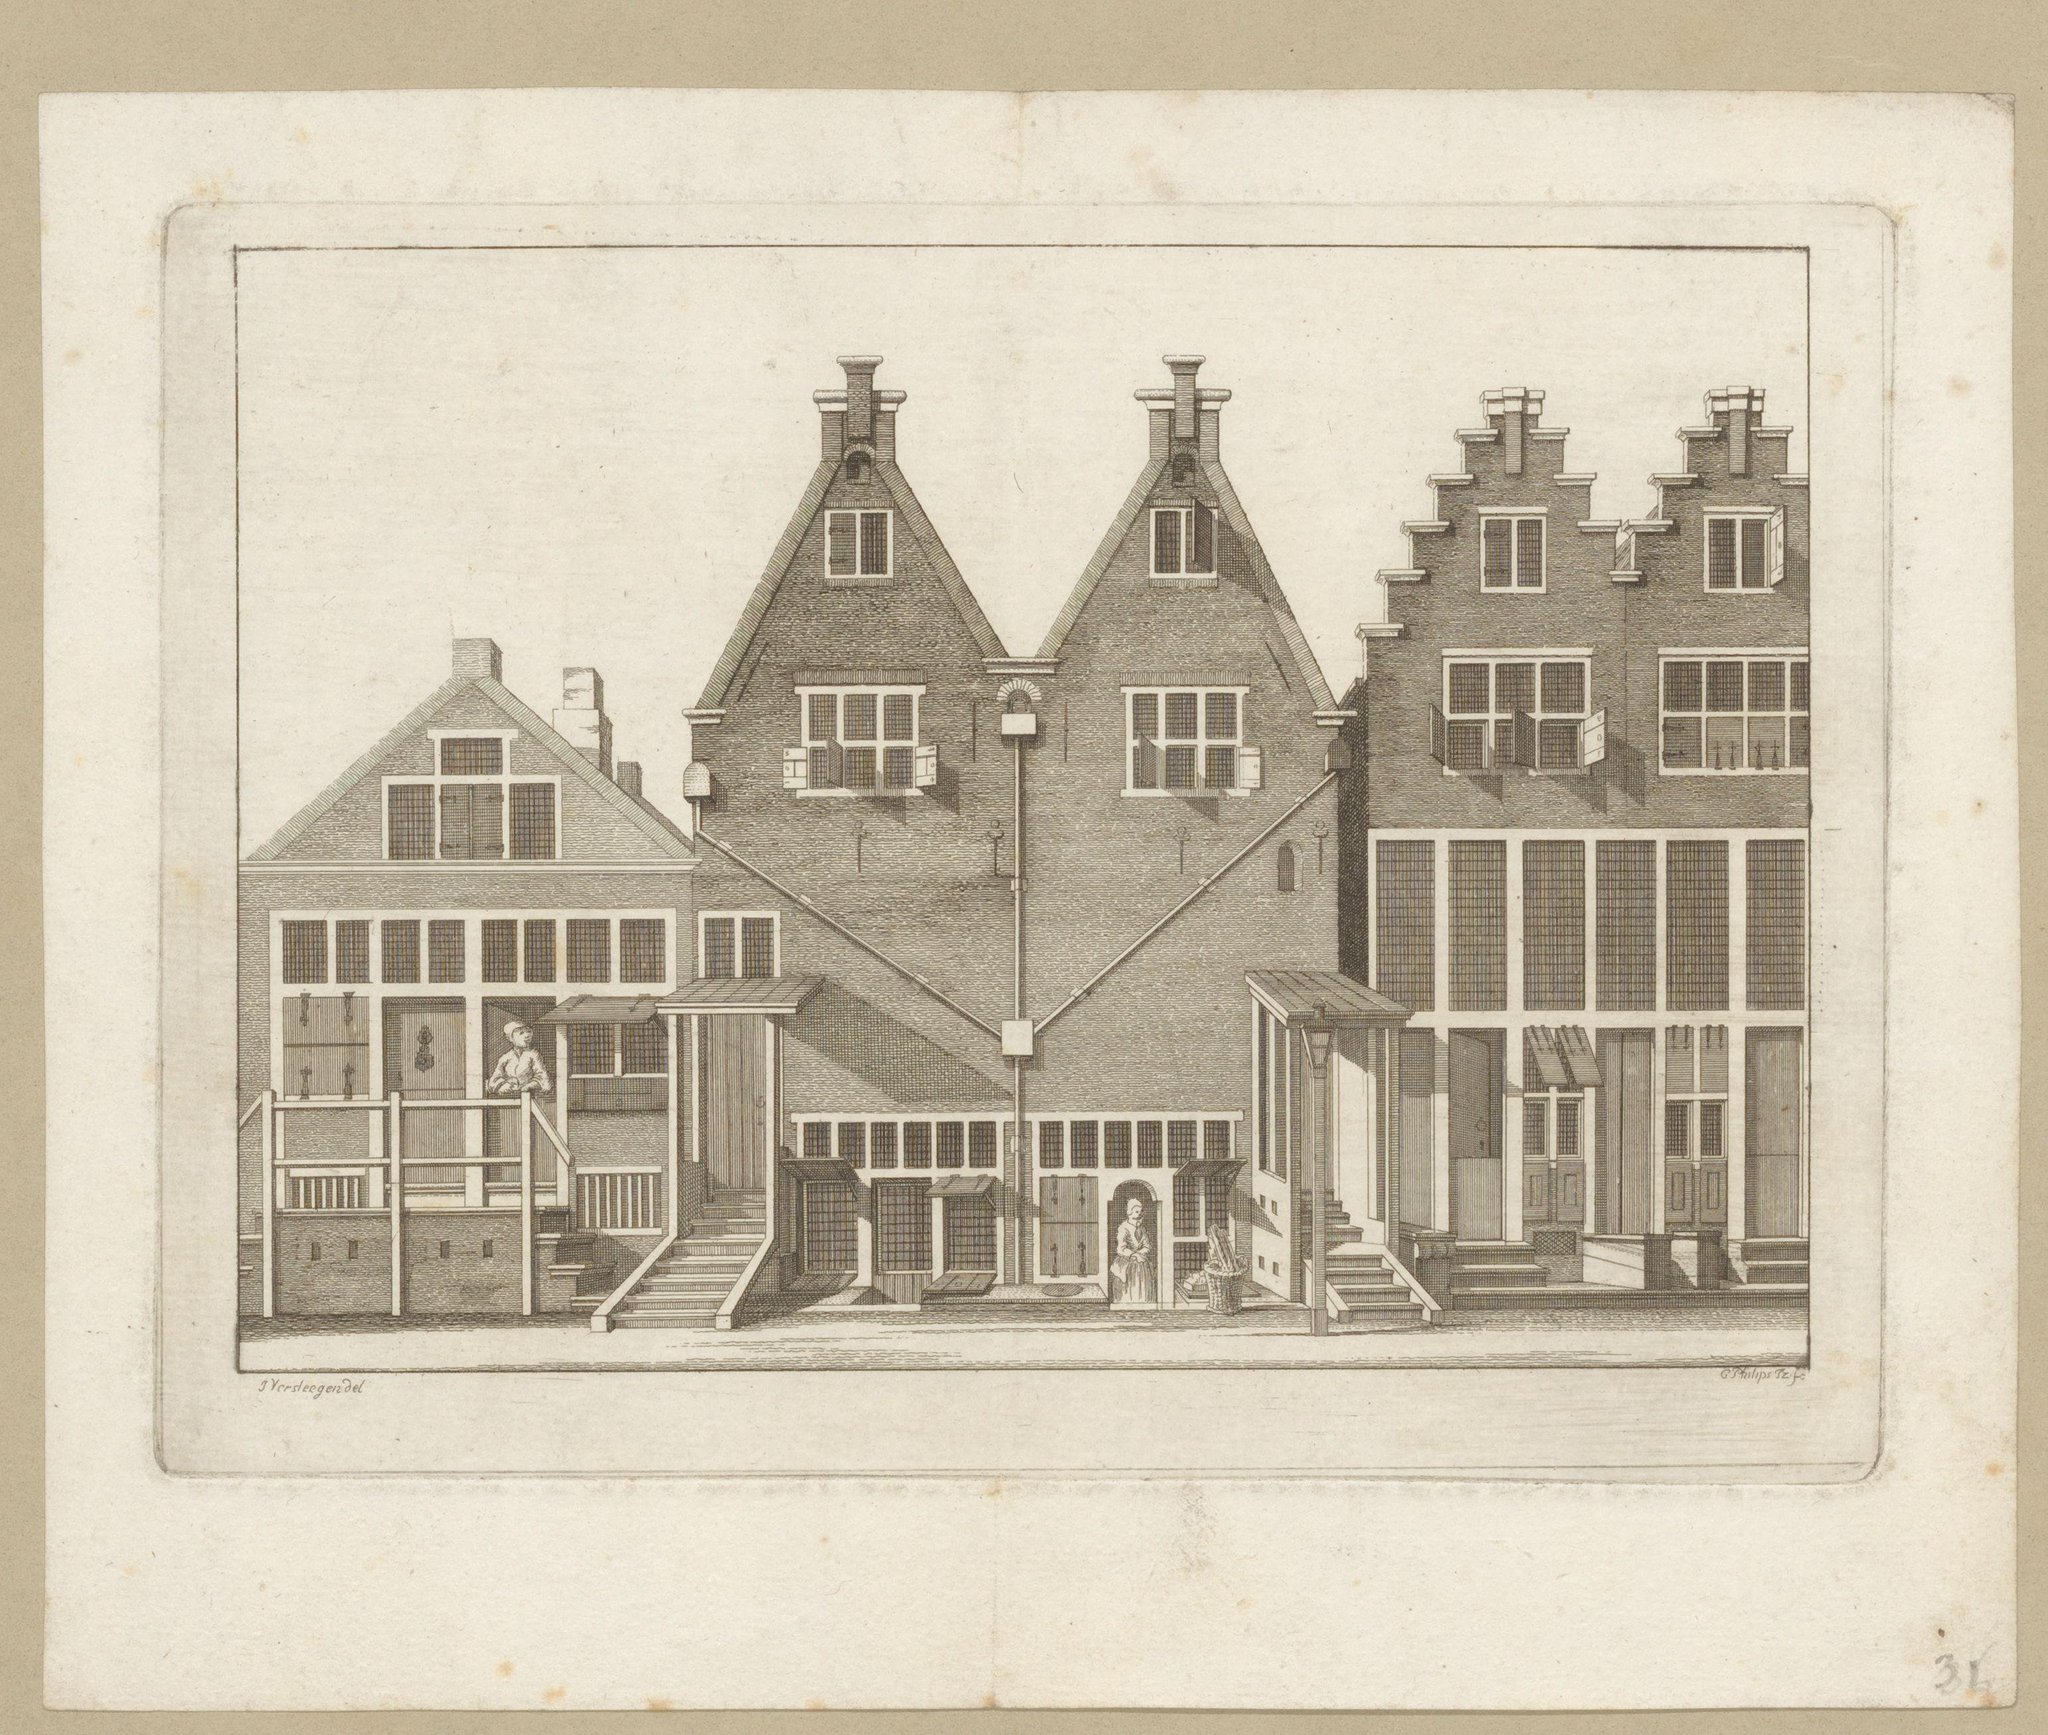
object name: print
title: Gezicht op de Doopsgezinde Kerk van de Jan Jacobsgezinden in de Bloemstraat te Amsterdam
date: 1752-1789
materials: paper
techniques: etching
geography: amsterdam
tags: protestant churches and denominations (mennonites), church (exterior), street (+ city(-scape) with figures, staffage)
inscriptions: collector's mark: Lugt 1641b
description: Onderwerpsrubriek binnen de Atlas Amsterdam: Kerkwezen: Gebouwen diverse gemeenten: Doopsgezinde Gemeente / Gebouwen, vroegere kerken (Arke Noachs / Jan Jacobsgezinden / De Toren / De Zon).